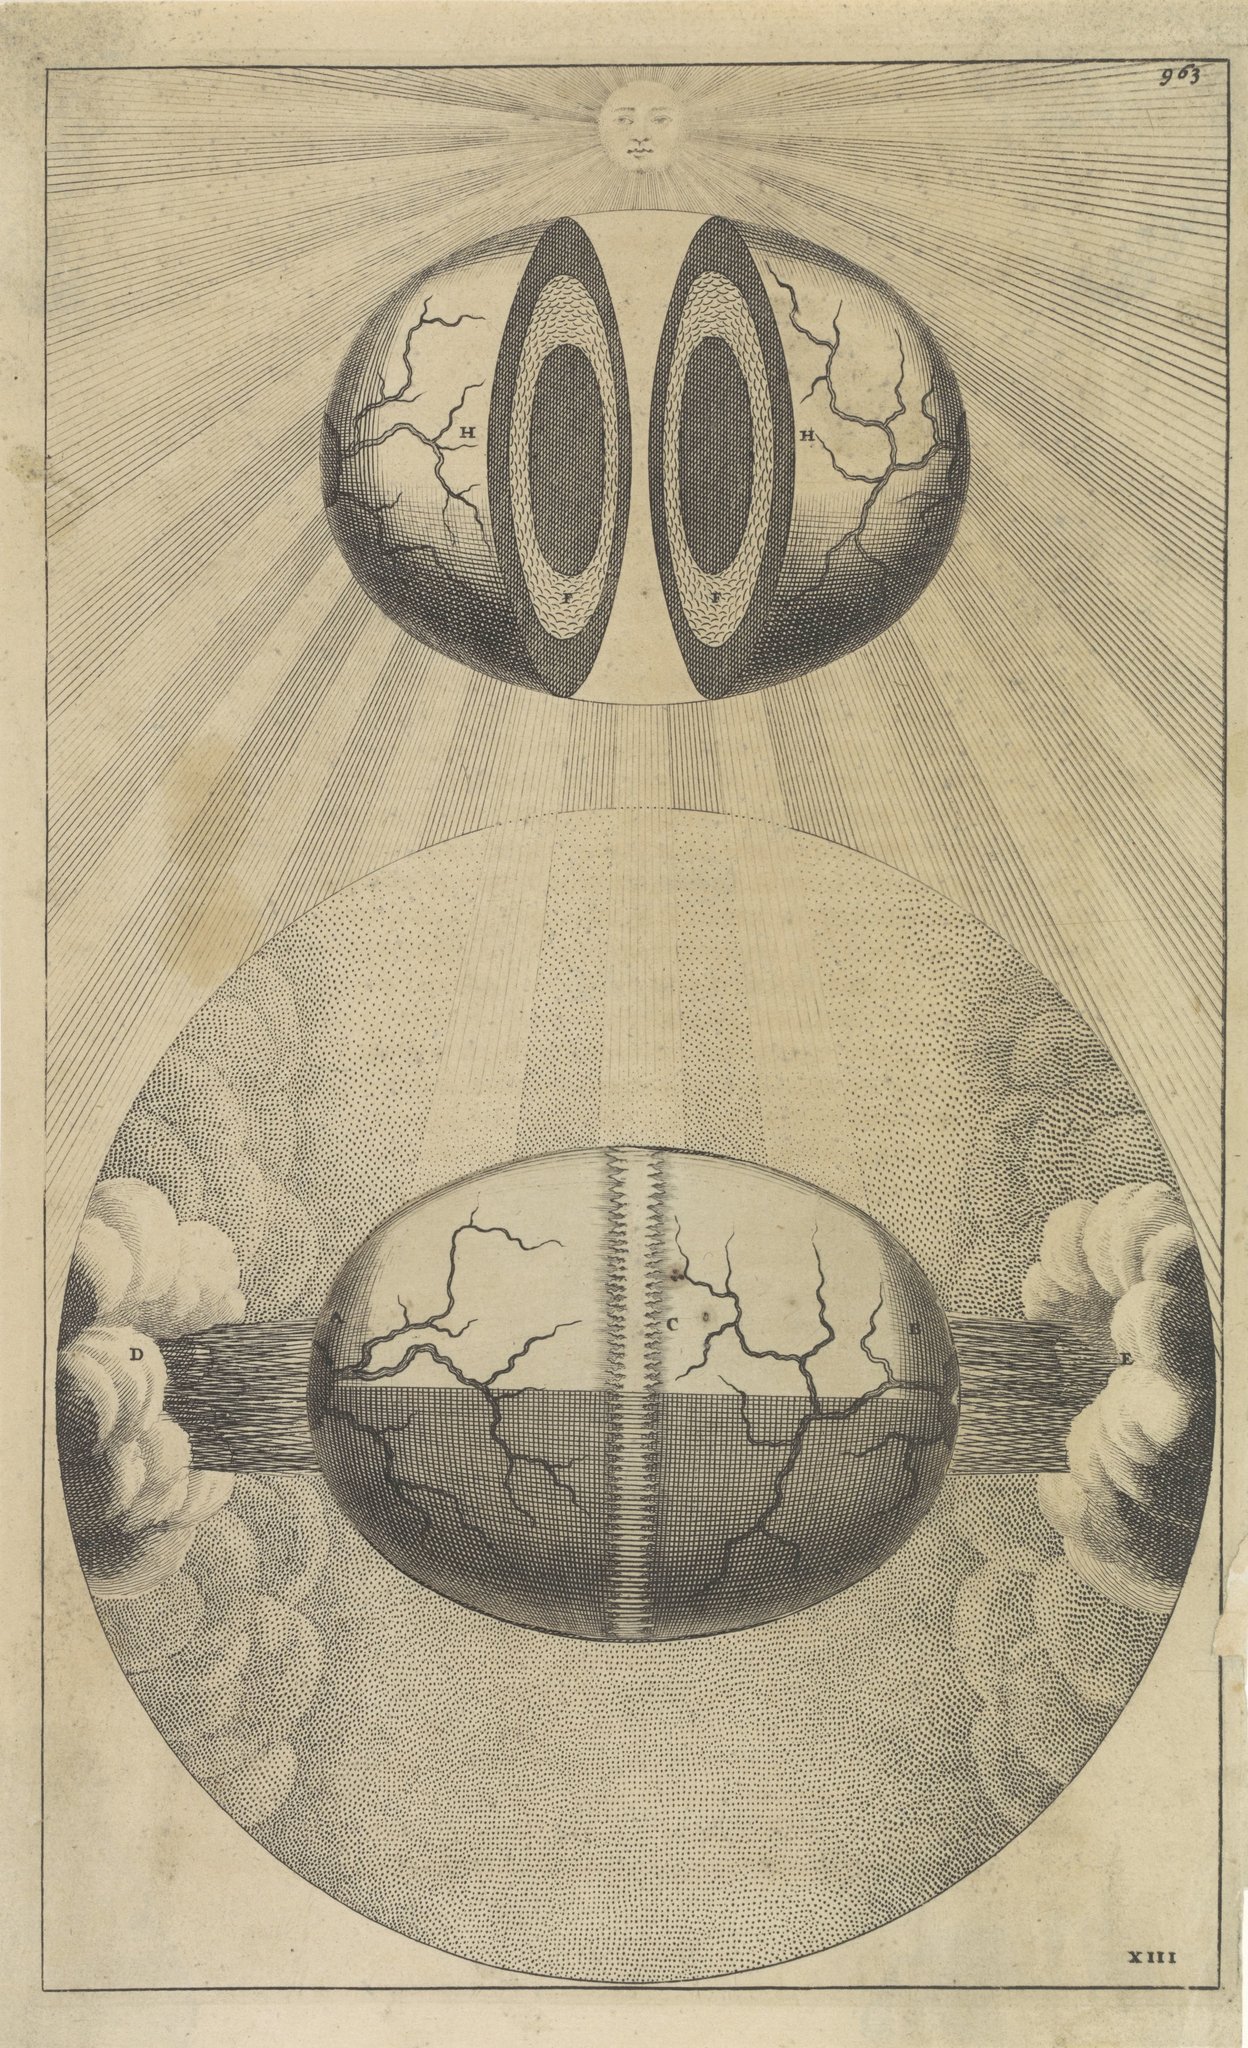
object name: book illustration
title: Wereldbollen in twee helften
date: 1690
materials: paper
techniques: engraving, etching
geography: netherlands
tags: earth, world as celestial body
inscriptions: collector's mark: Lugt 2228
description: Mogelijk gebruikt als boekillustratie in: Goeree, Willem. Voor-bereidselen tot de bybelsche wysheid, en gebruik der heilige en kerklijke historien. 2 delen. Amsterdam: Willem Goeree, 1690.